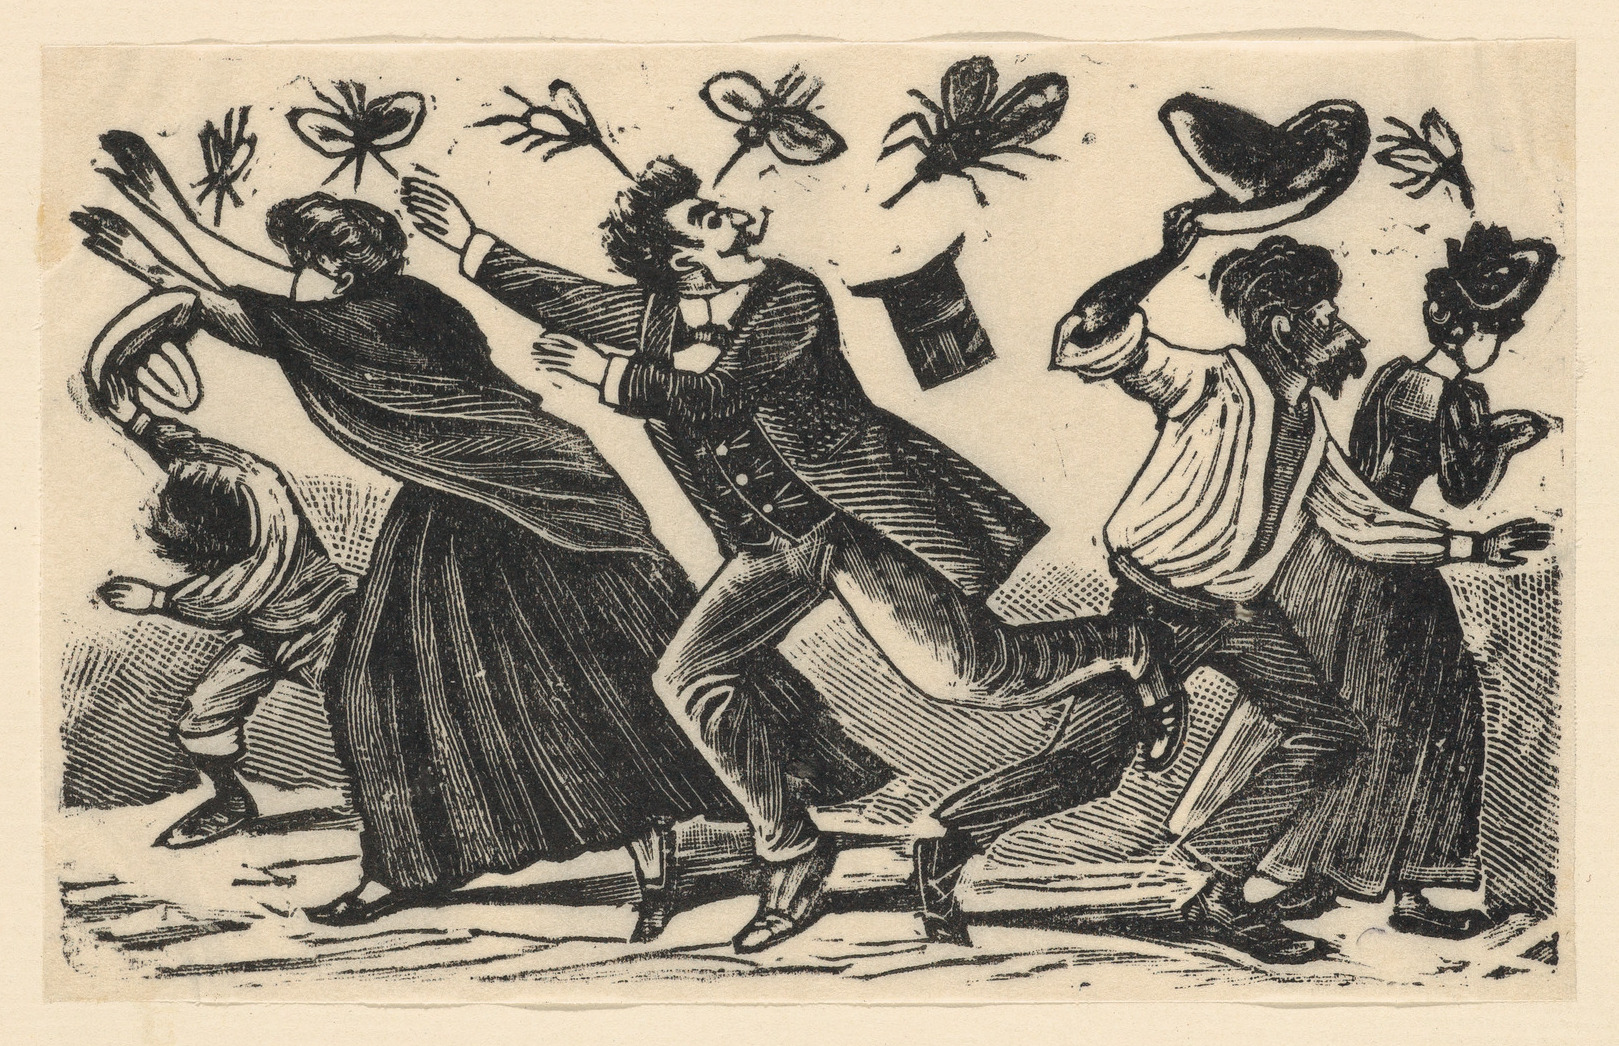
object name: print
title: The American mosquito that just appeared in Mexico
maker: josé guadalupe posada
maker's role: artist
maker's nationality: mexican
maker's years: 1852-1913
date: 1903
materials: metal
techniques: engraving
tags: satire,men,women,insects